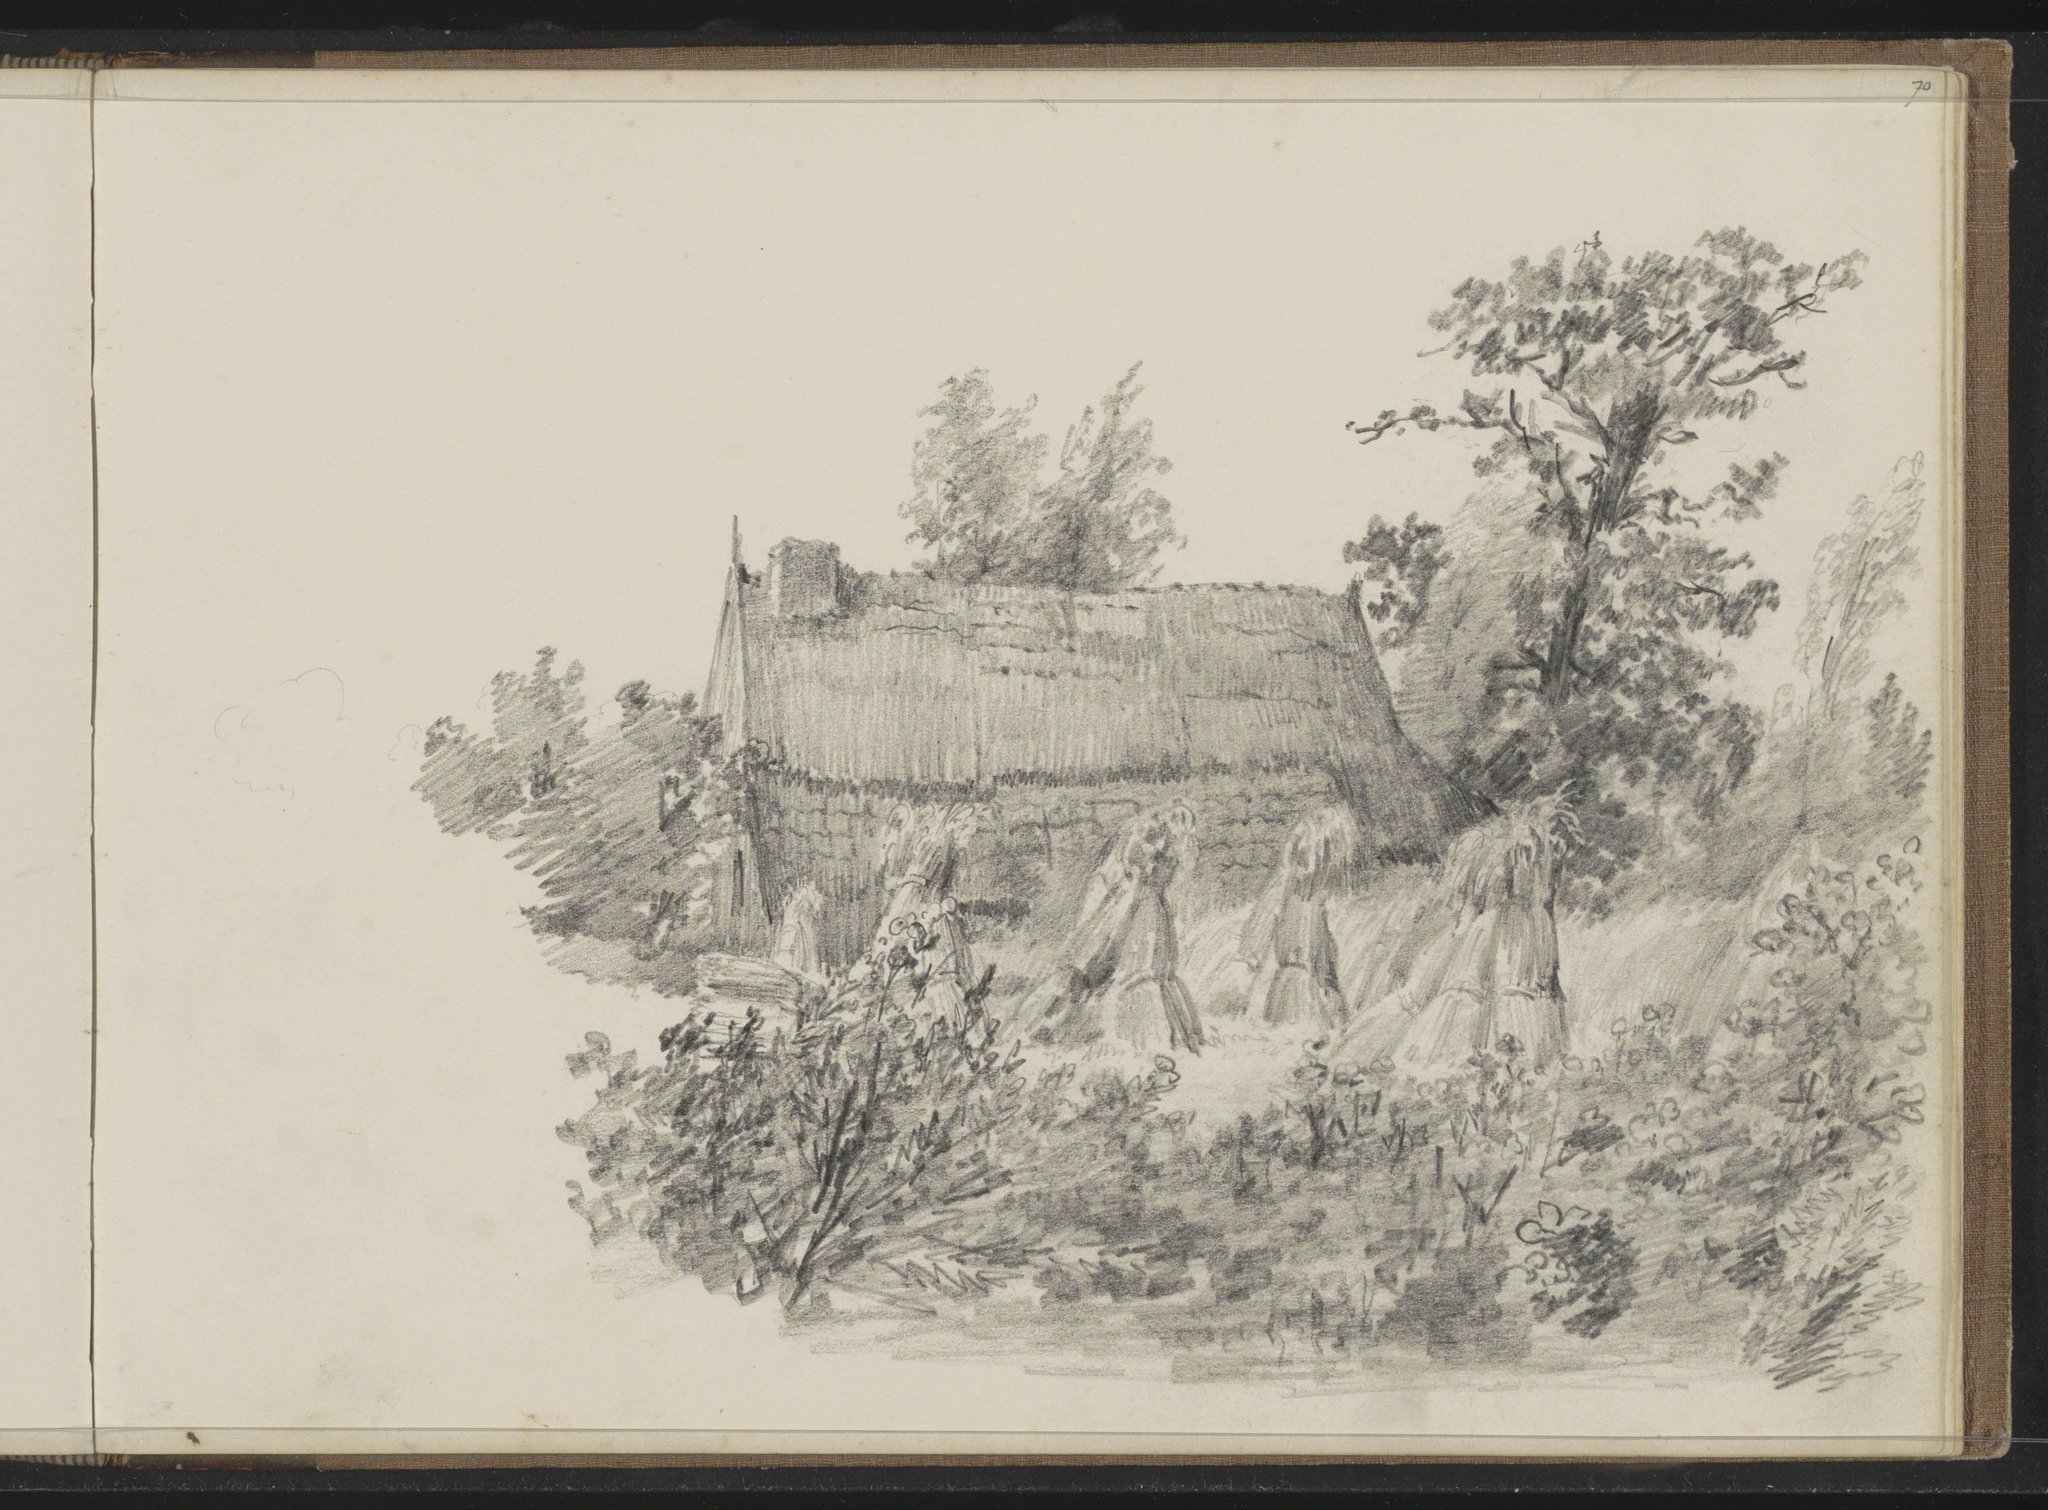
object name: sketchbook leaf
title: Korenschoven op een veld naast een boerderij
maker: hendrik valkenburg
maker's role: draughtsman, painter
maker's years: 1826-1896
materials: paper, pencil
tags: sheaf, farm (building)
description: Blad 70 recto uit een schetsboek met 77 bladen.